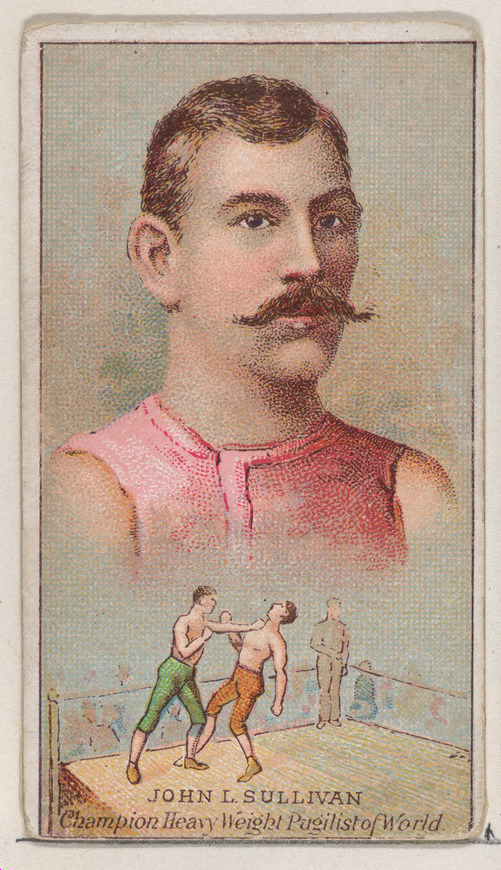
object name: print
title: John L. Sullivan, Champion Heavy Weight Pugilist of the World, from the Champions of Games and Sports series (N184, Type 2) issued by W.S. Kimball & Co.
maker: w.s. kimball & co.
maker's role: publisher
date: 1887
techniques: color lithograph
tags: men,boxing,athletes